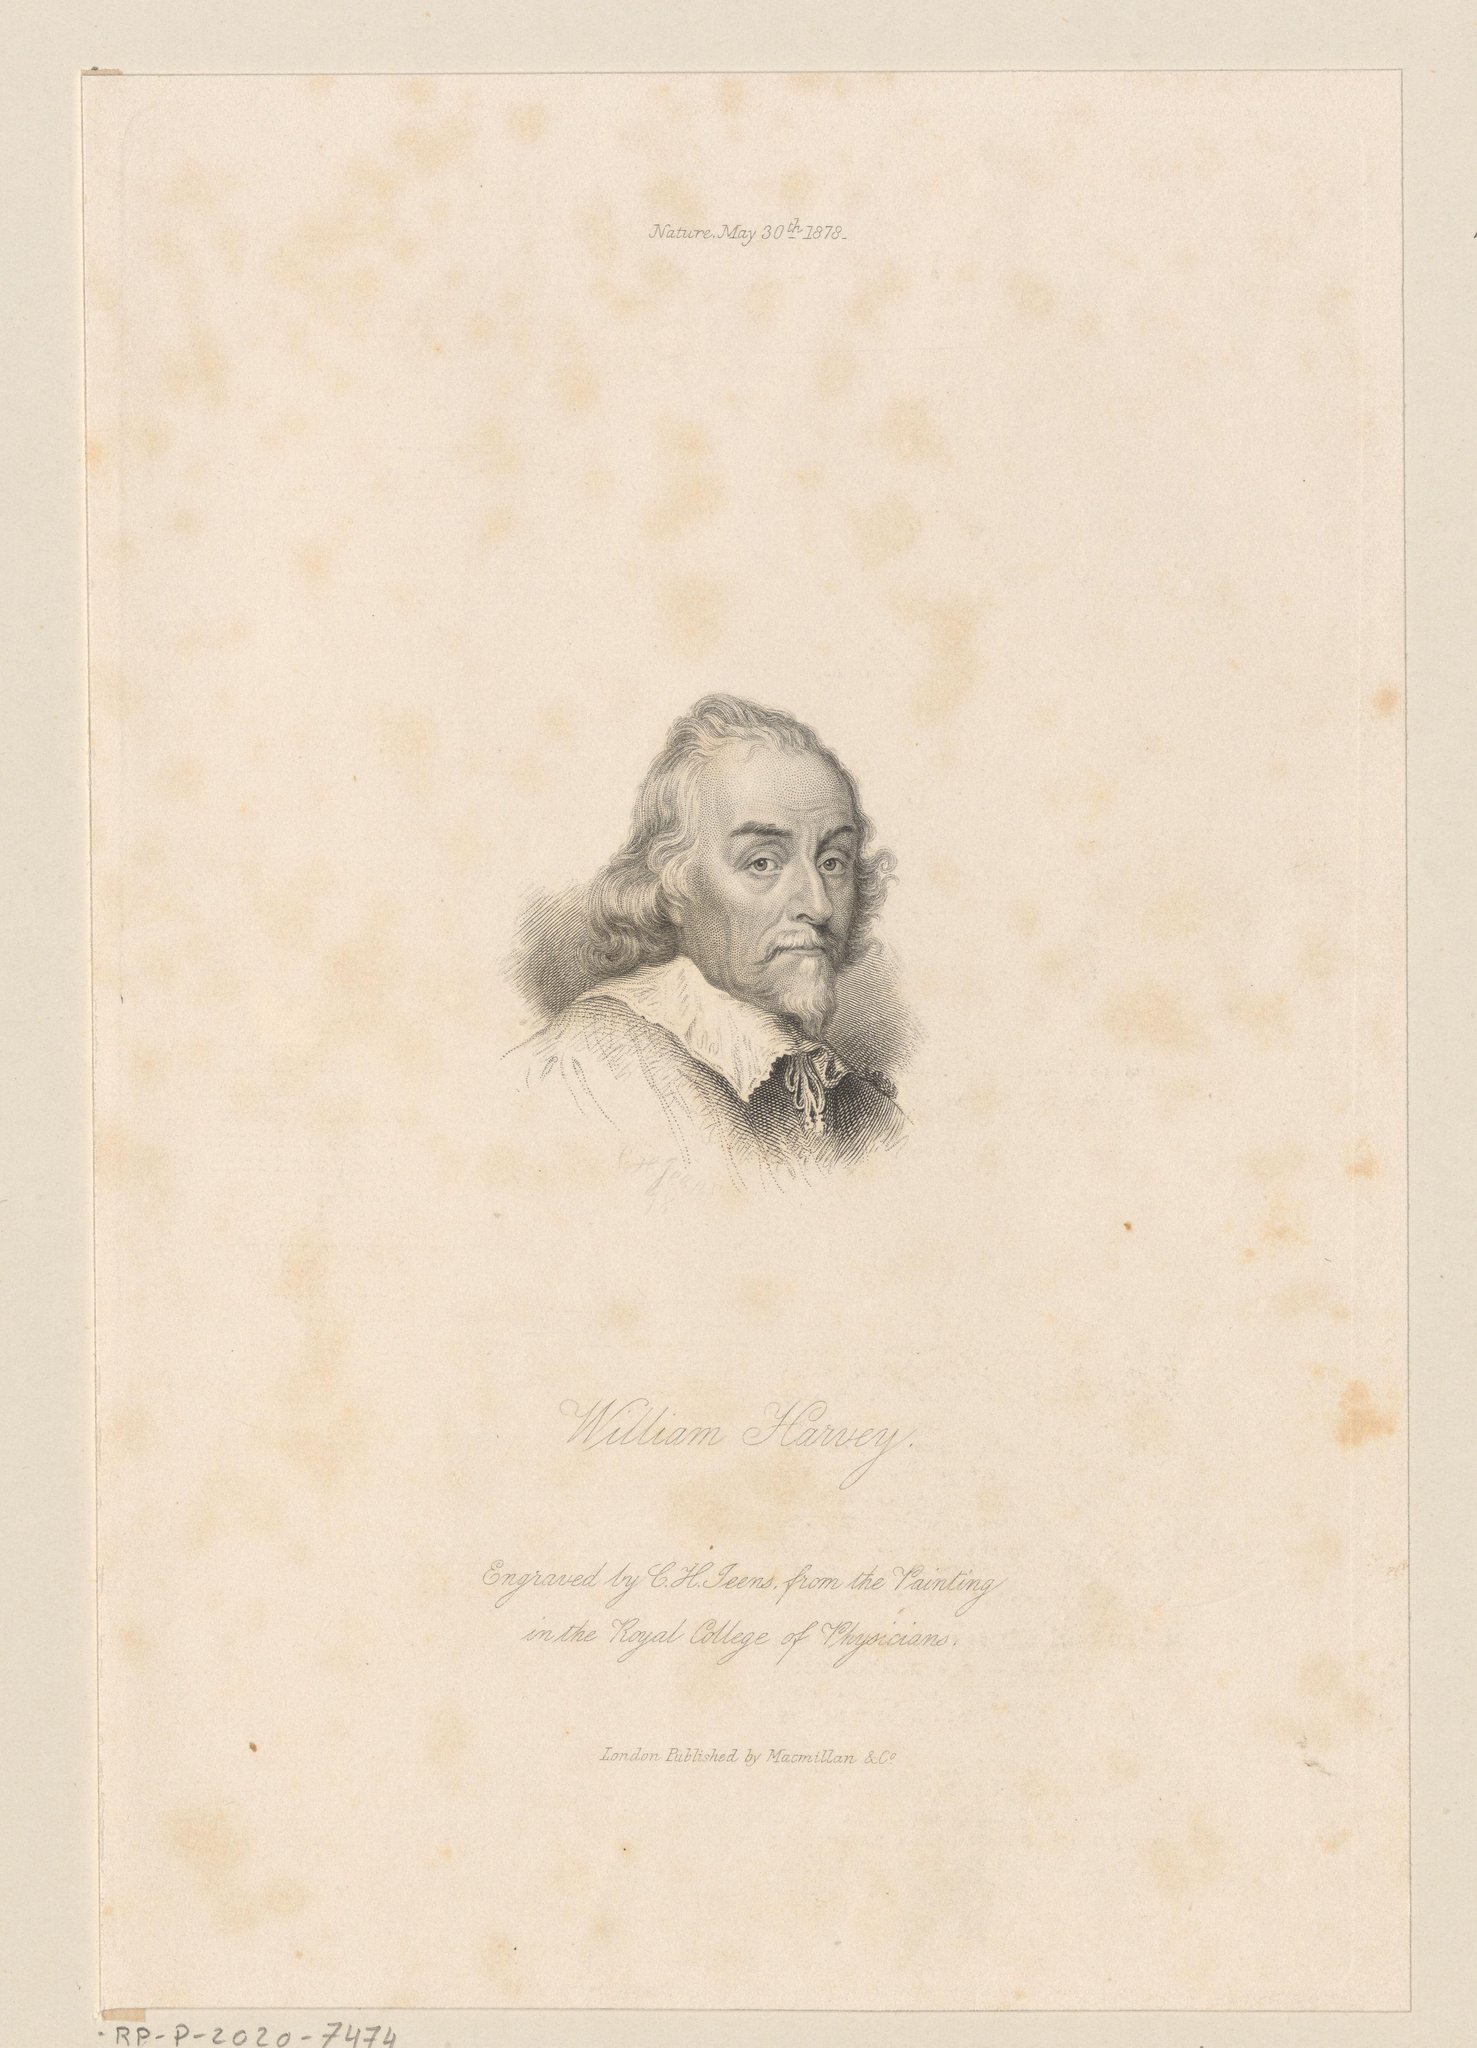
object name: print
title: Portret van William Harvey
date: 1878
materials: paper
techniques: engraving, etching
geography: london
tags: william harvey, historical persons, physician, doctor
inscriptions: date